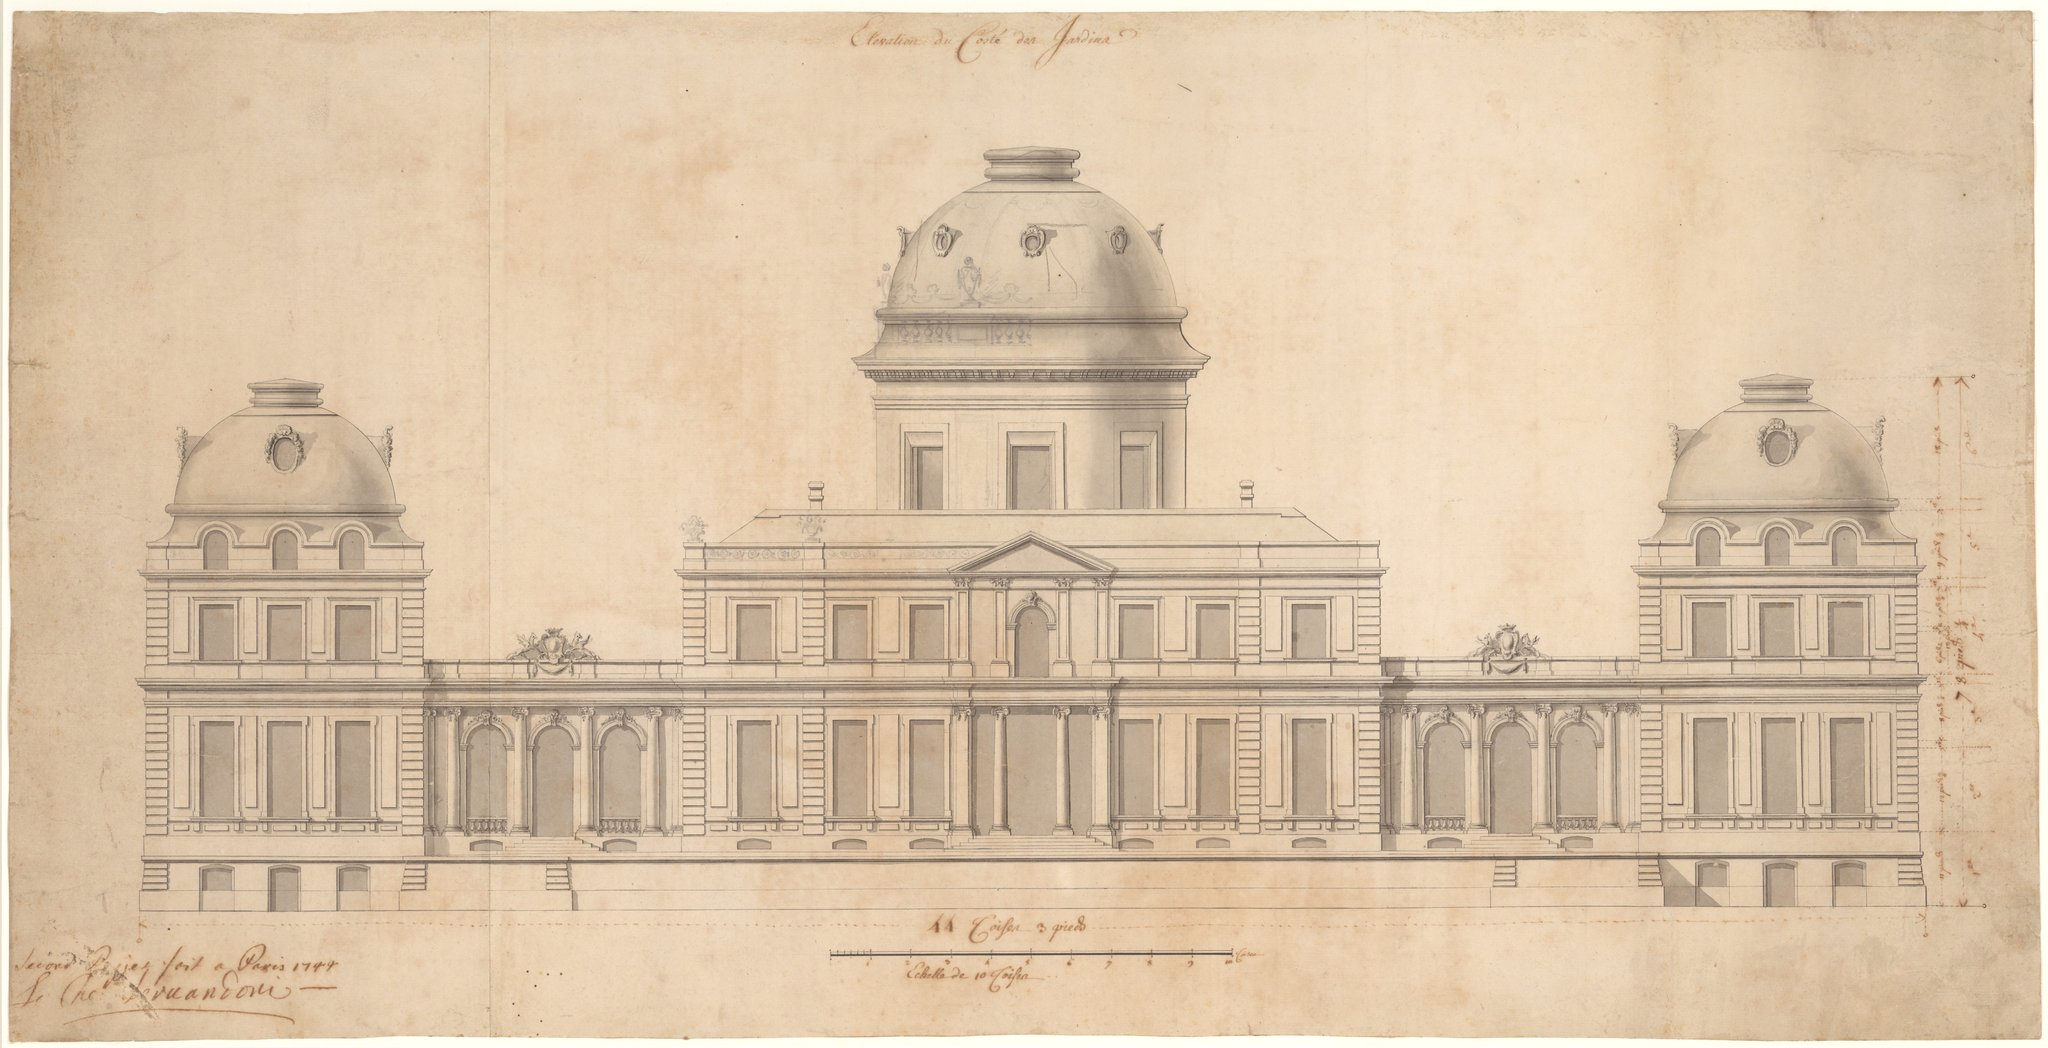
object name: drawing ornament architecture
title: Design for the Garden Façade of a Palace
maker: giovanni niccolò servandoni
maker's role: artist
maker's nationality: italian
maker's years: 1695-1766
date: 1695-1766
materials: graphite, ink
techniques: brush, pen, wash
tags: architecture,palaces